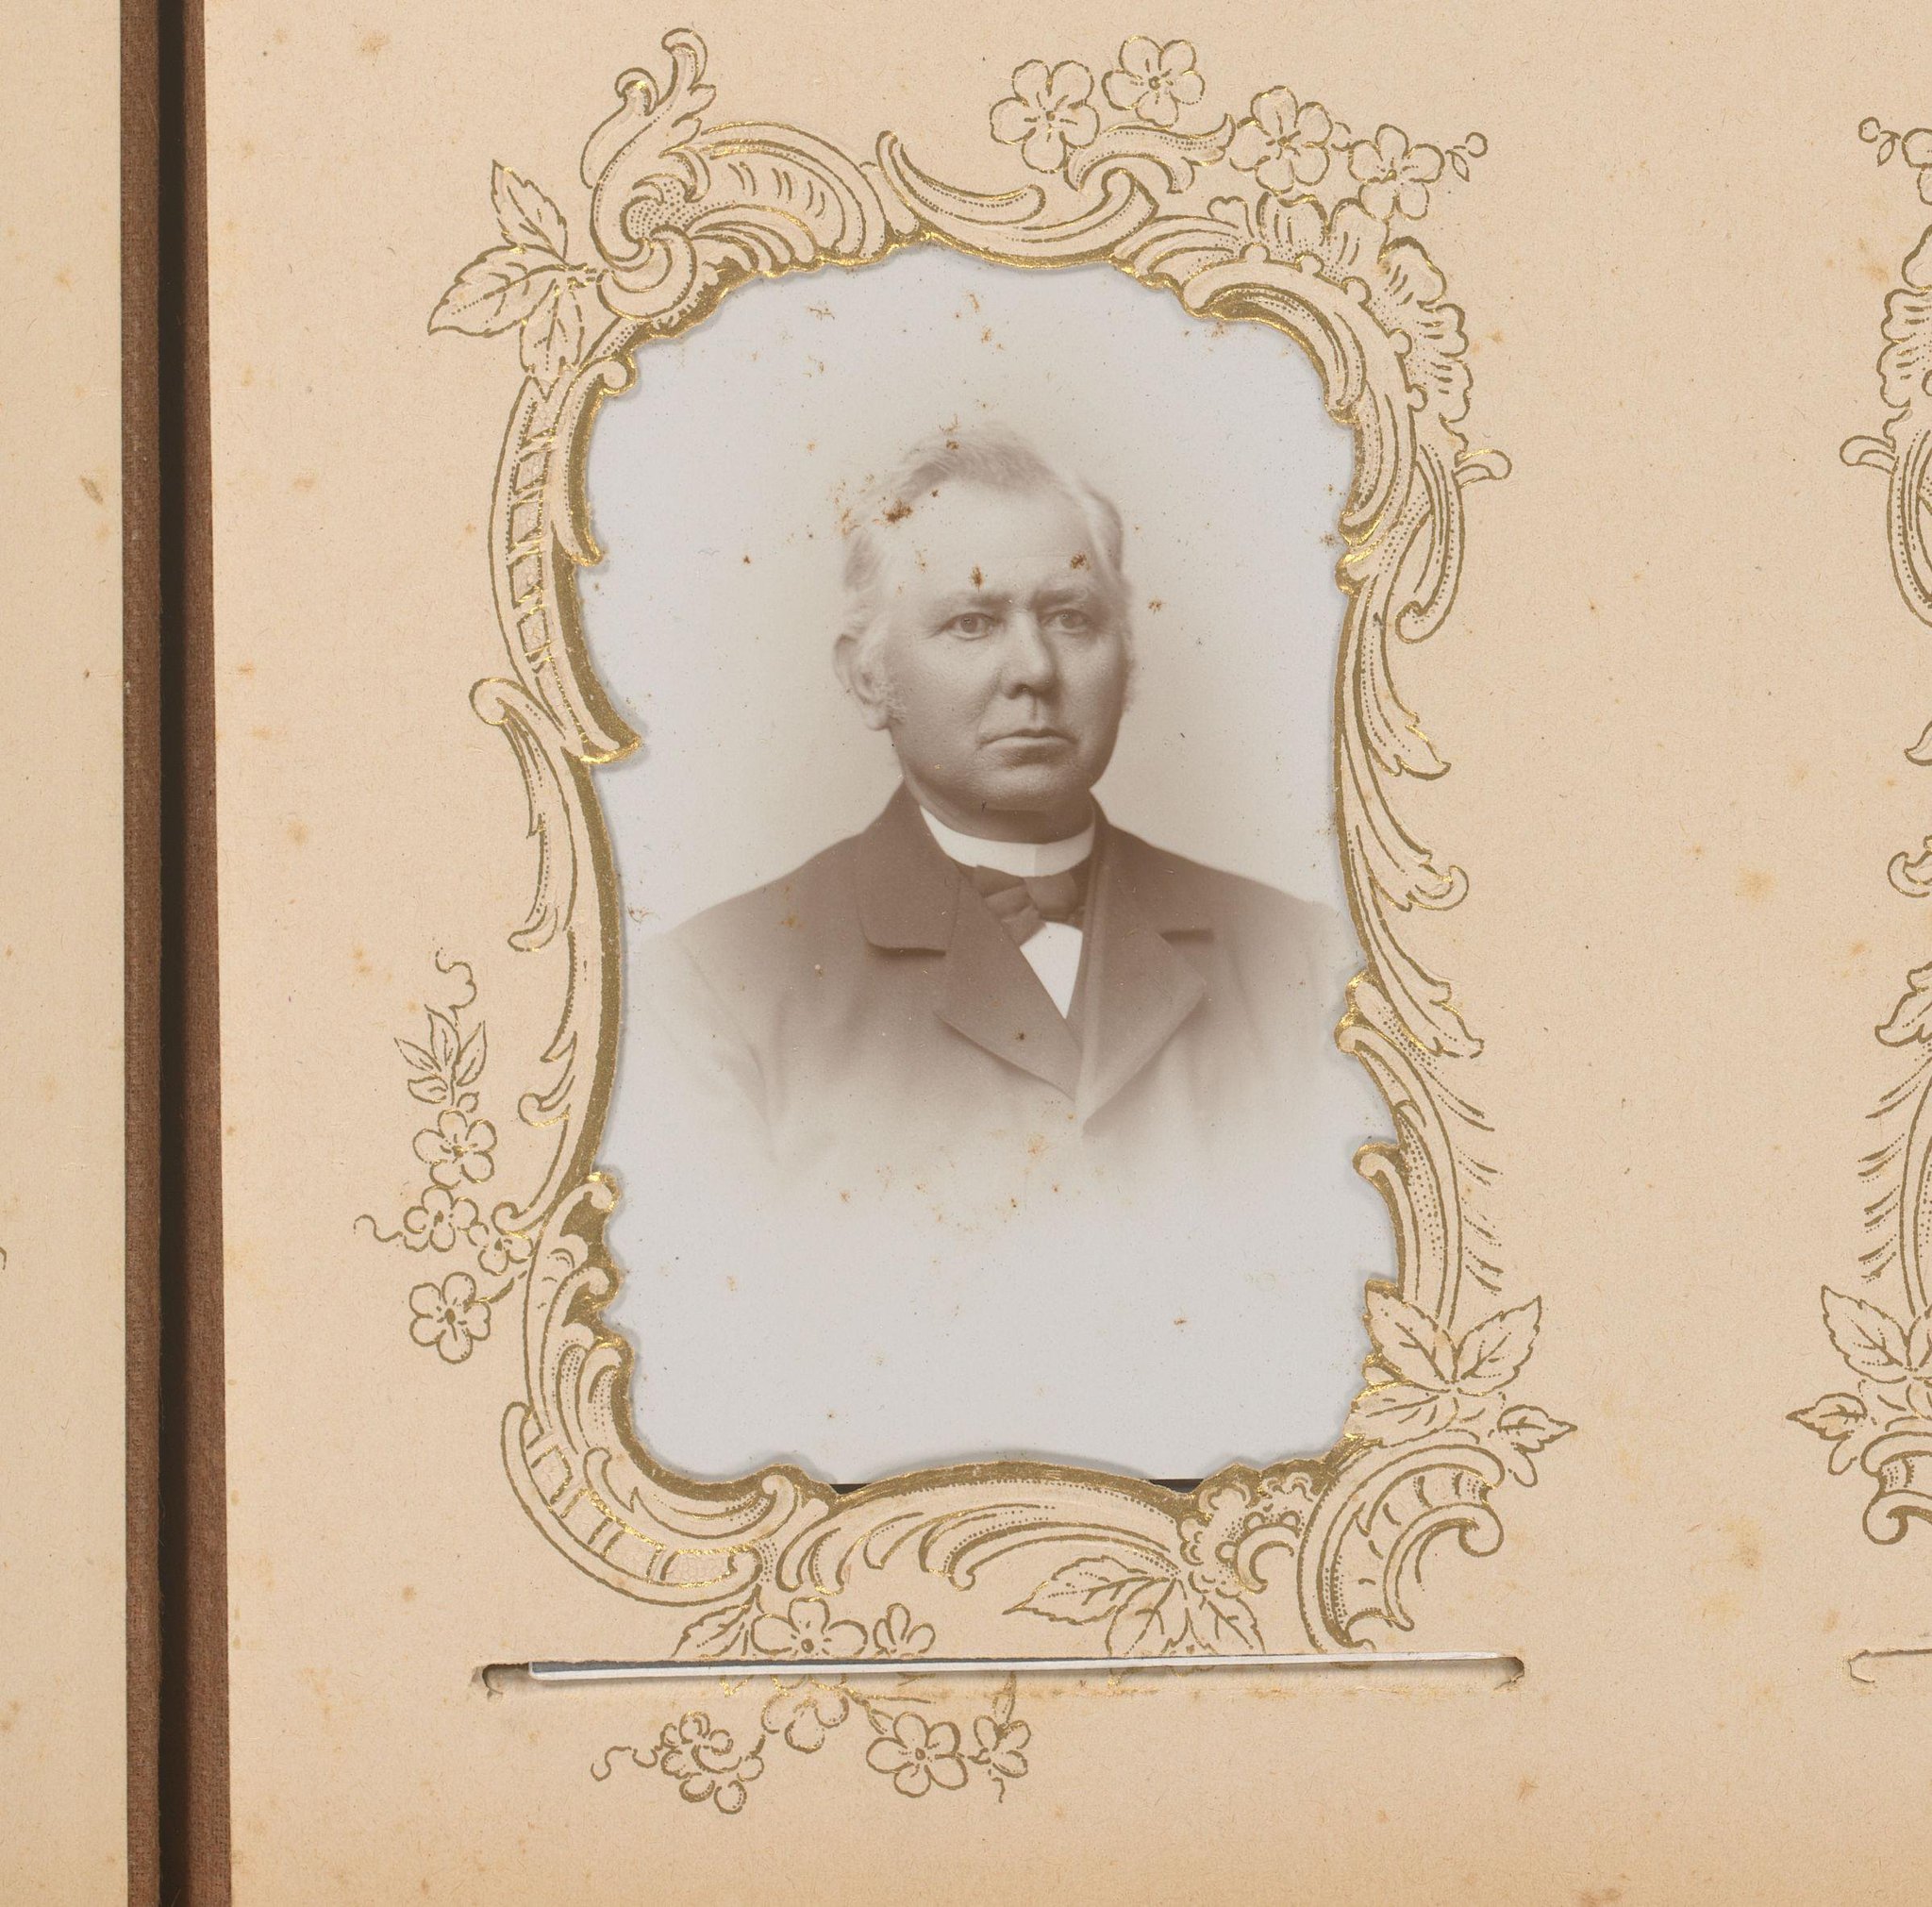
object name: album leaf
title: Portret van een man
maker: Anonymous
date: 1880-1910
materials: cardboard, photographic support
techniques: collodion silver print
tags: historical persons